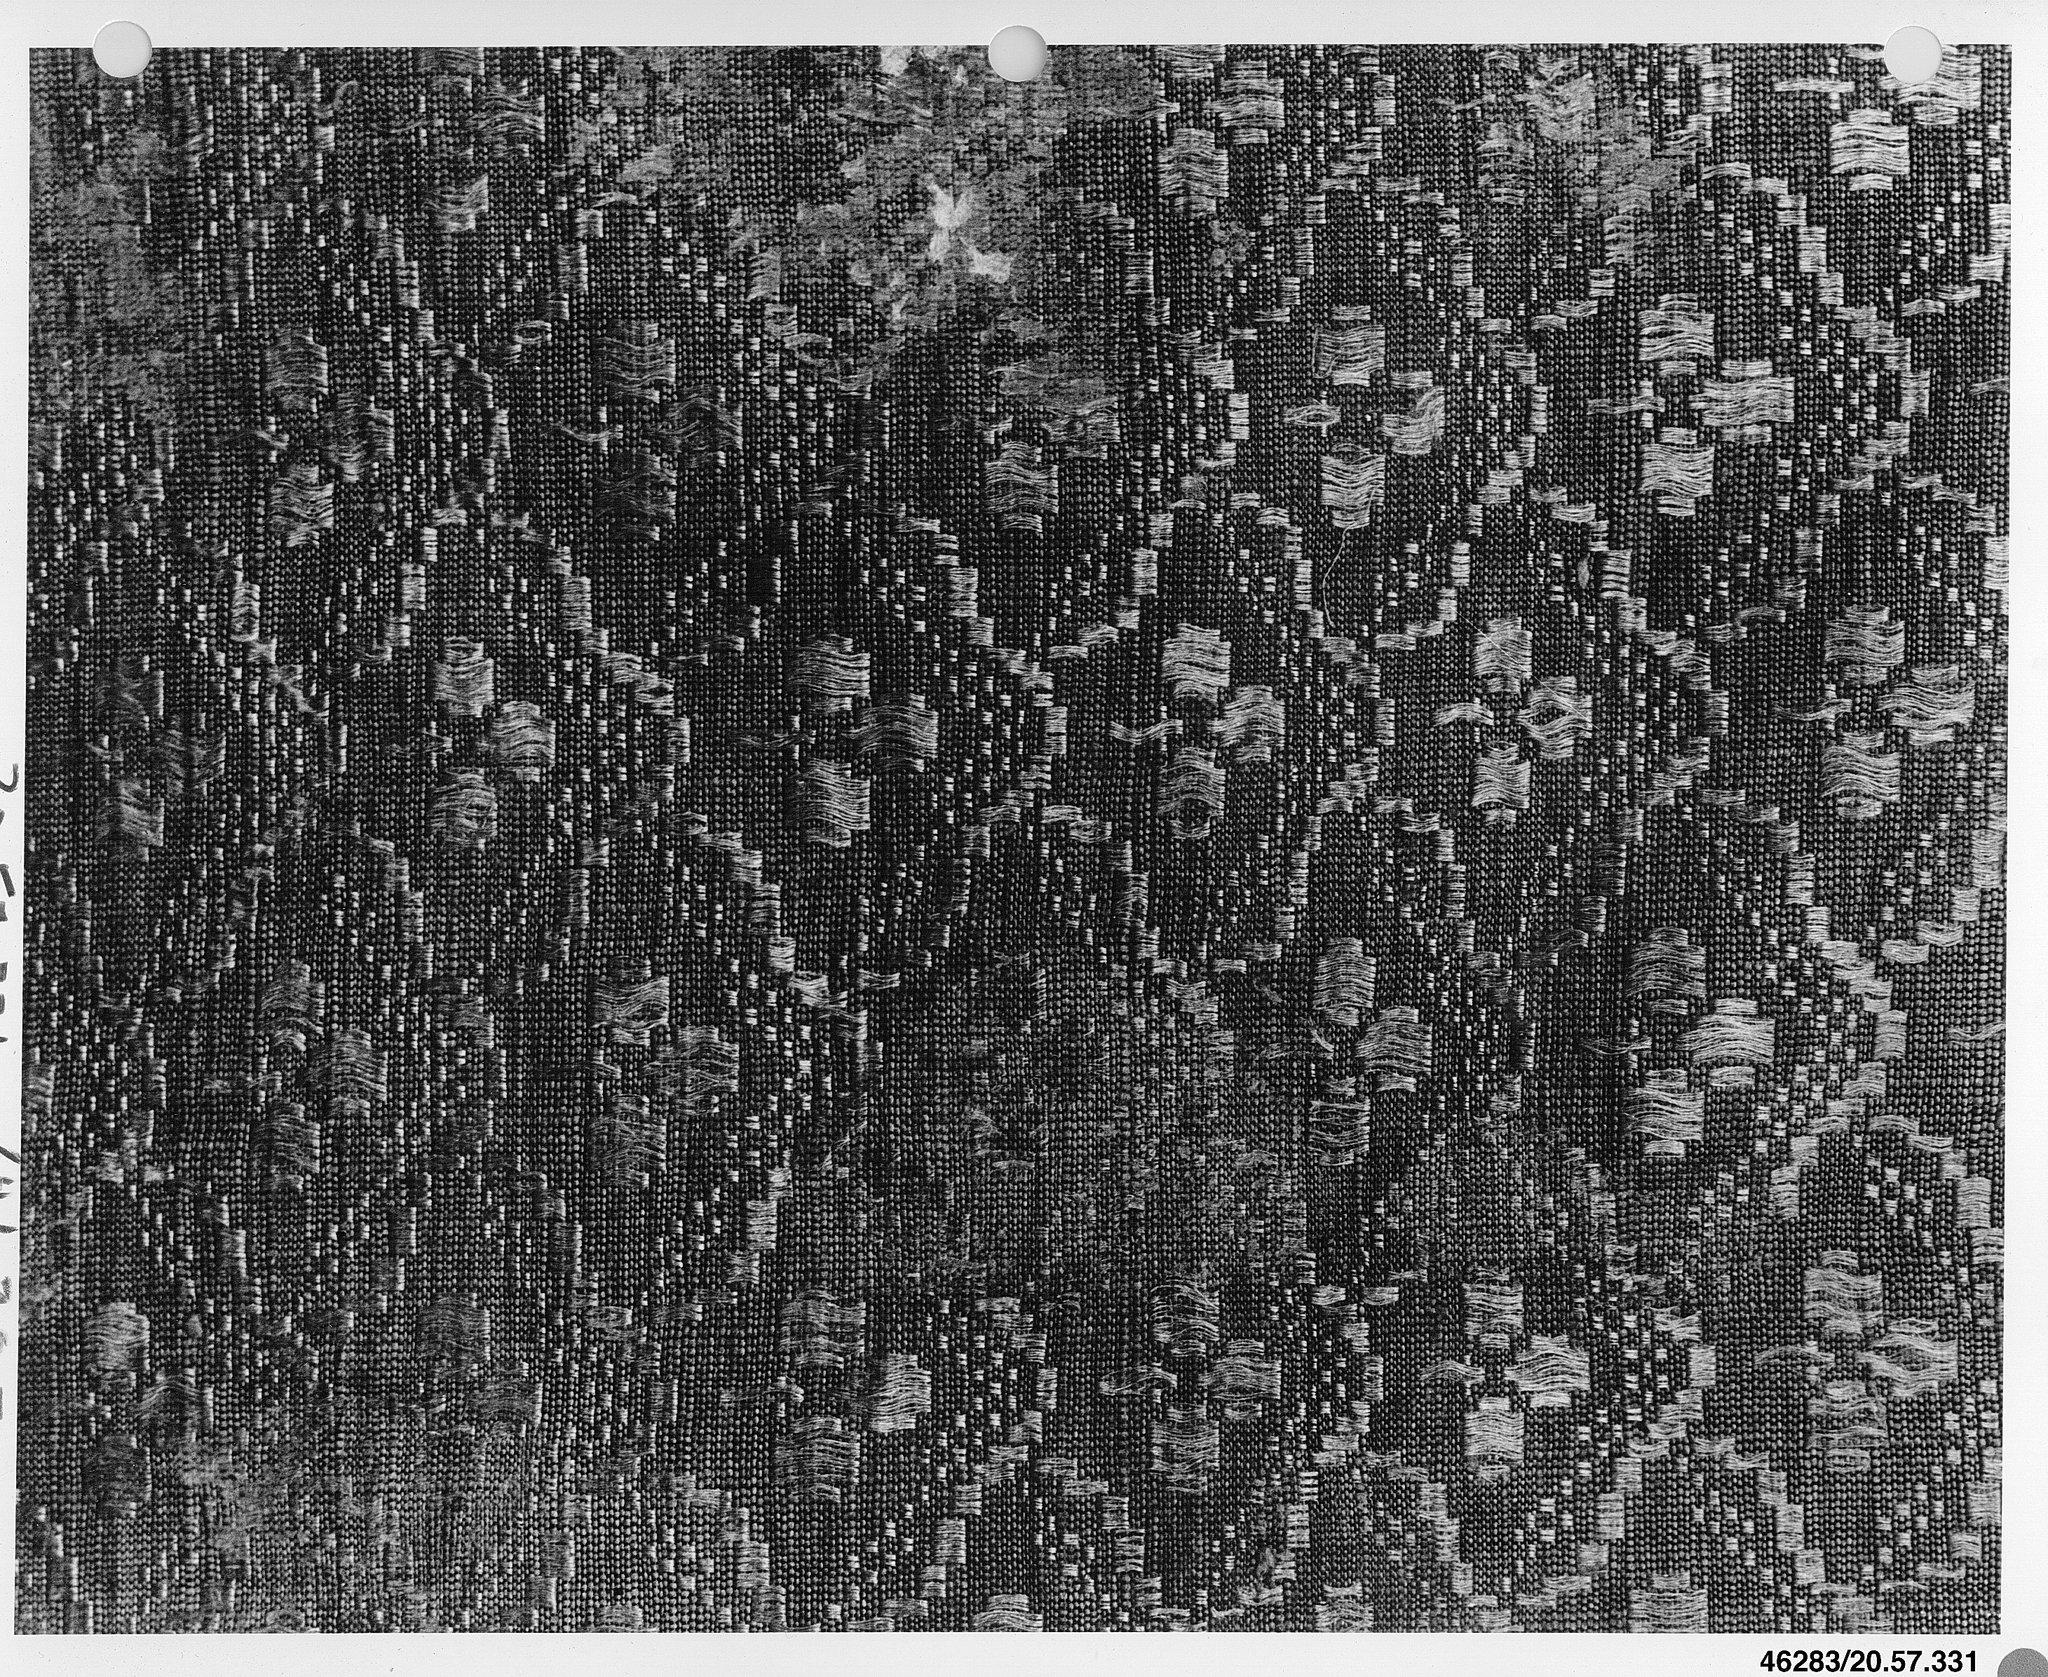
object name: piece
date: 1701-1800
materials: silk